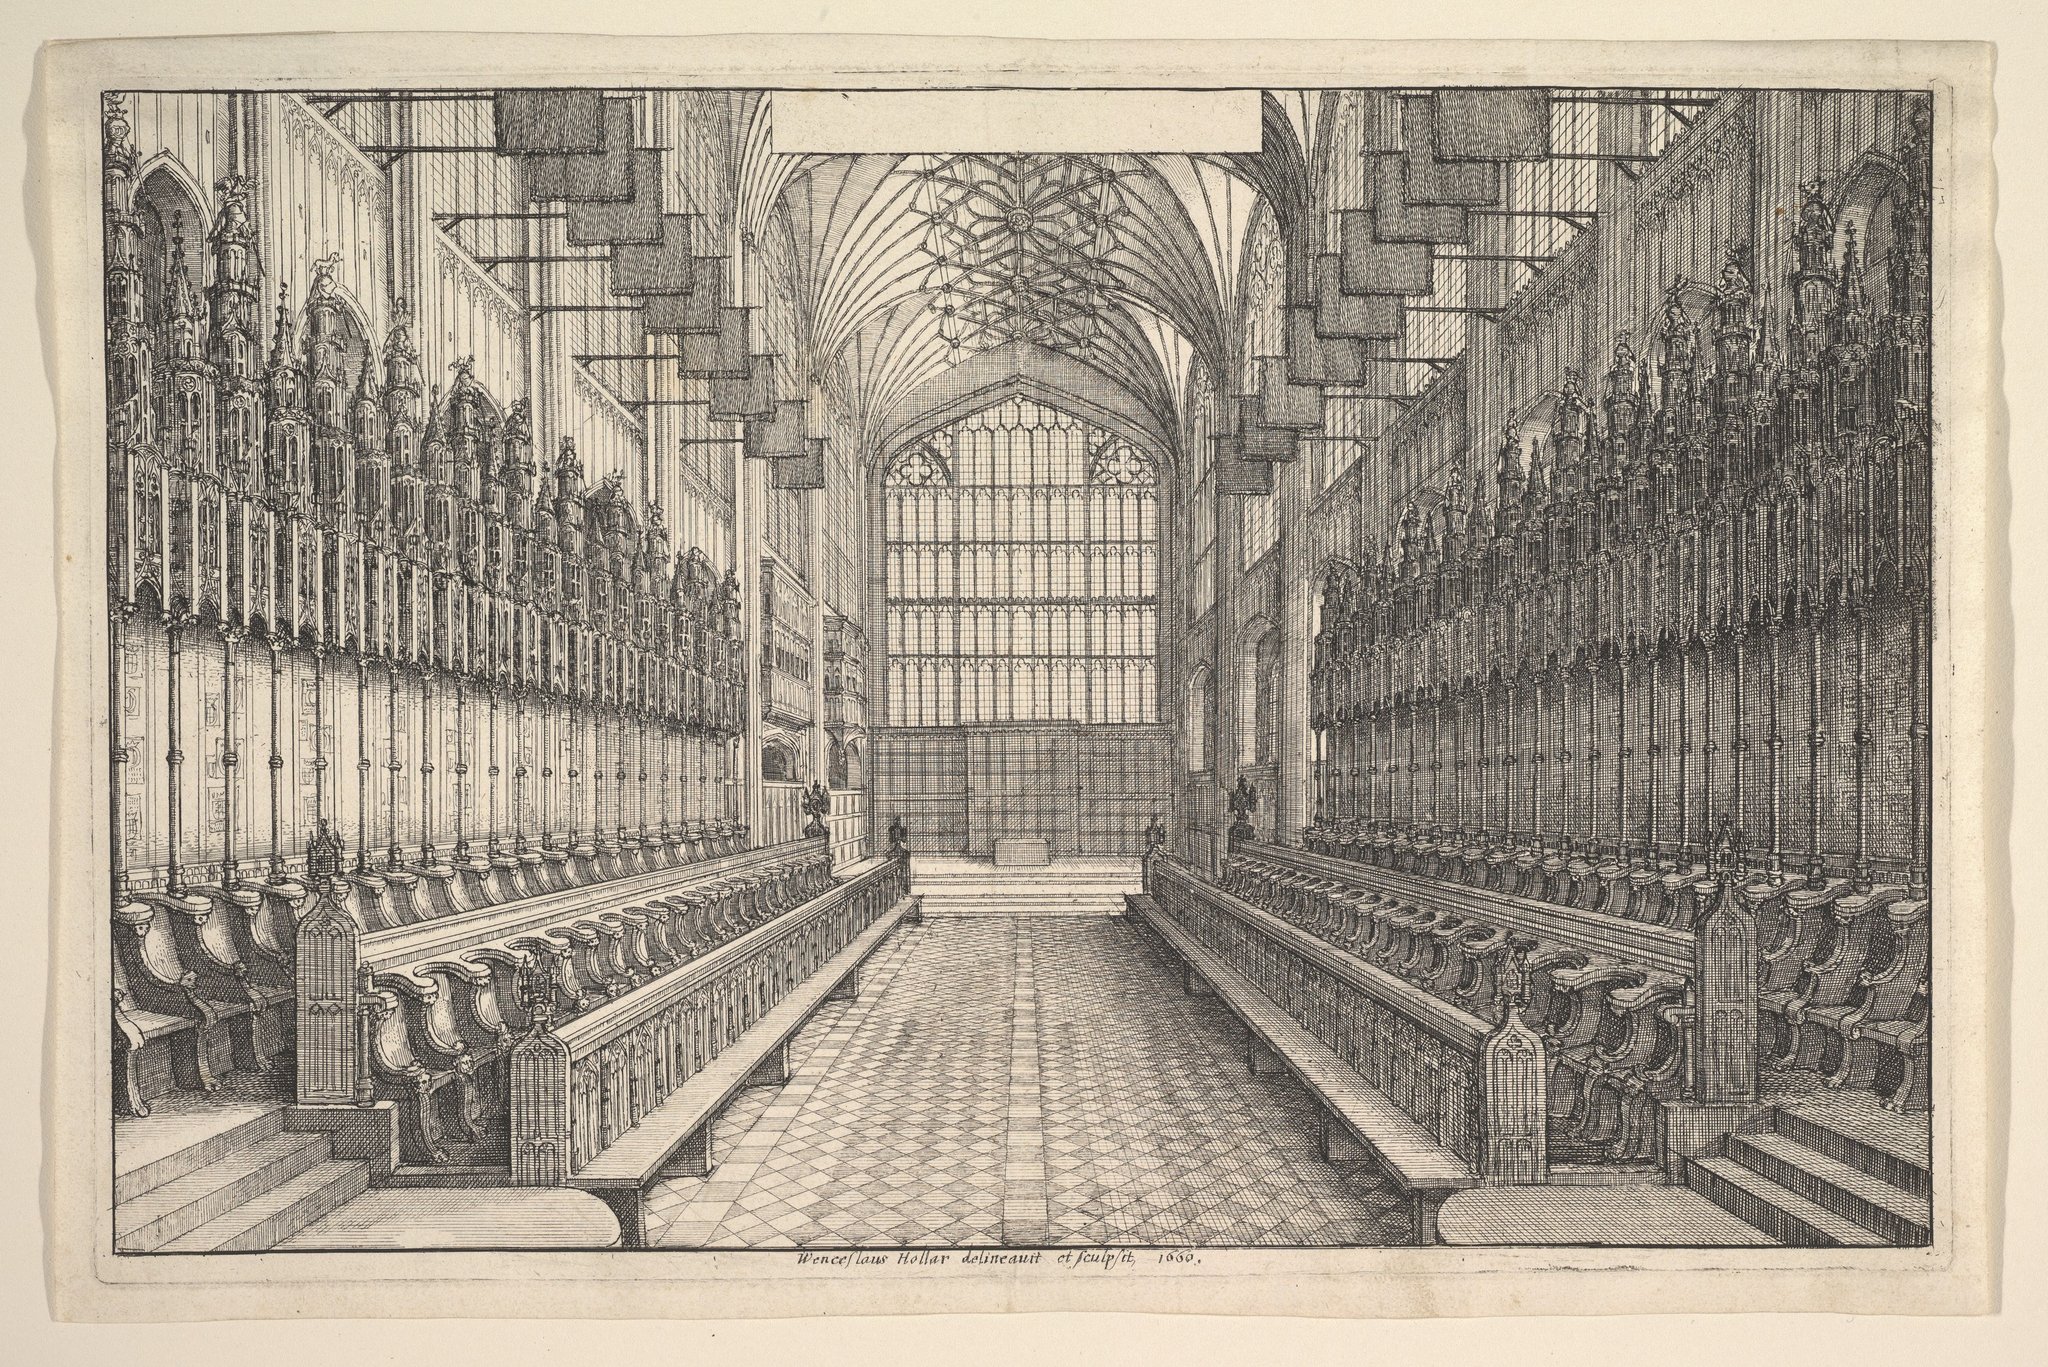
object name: print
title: Choir and stalls in St George's Chapel, Windsor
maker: wenceslaus hollar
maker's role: artist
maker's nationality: bohemian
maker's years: 1607-1677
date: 1660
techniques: etching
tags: interiors,churches